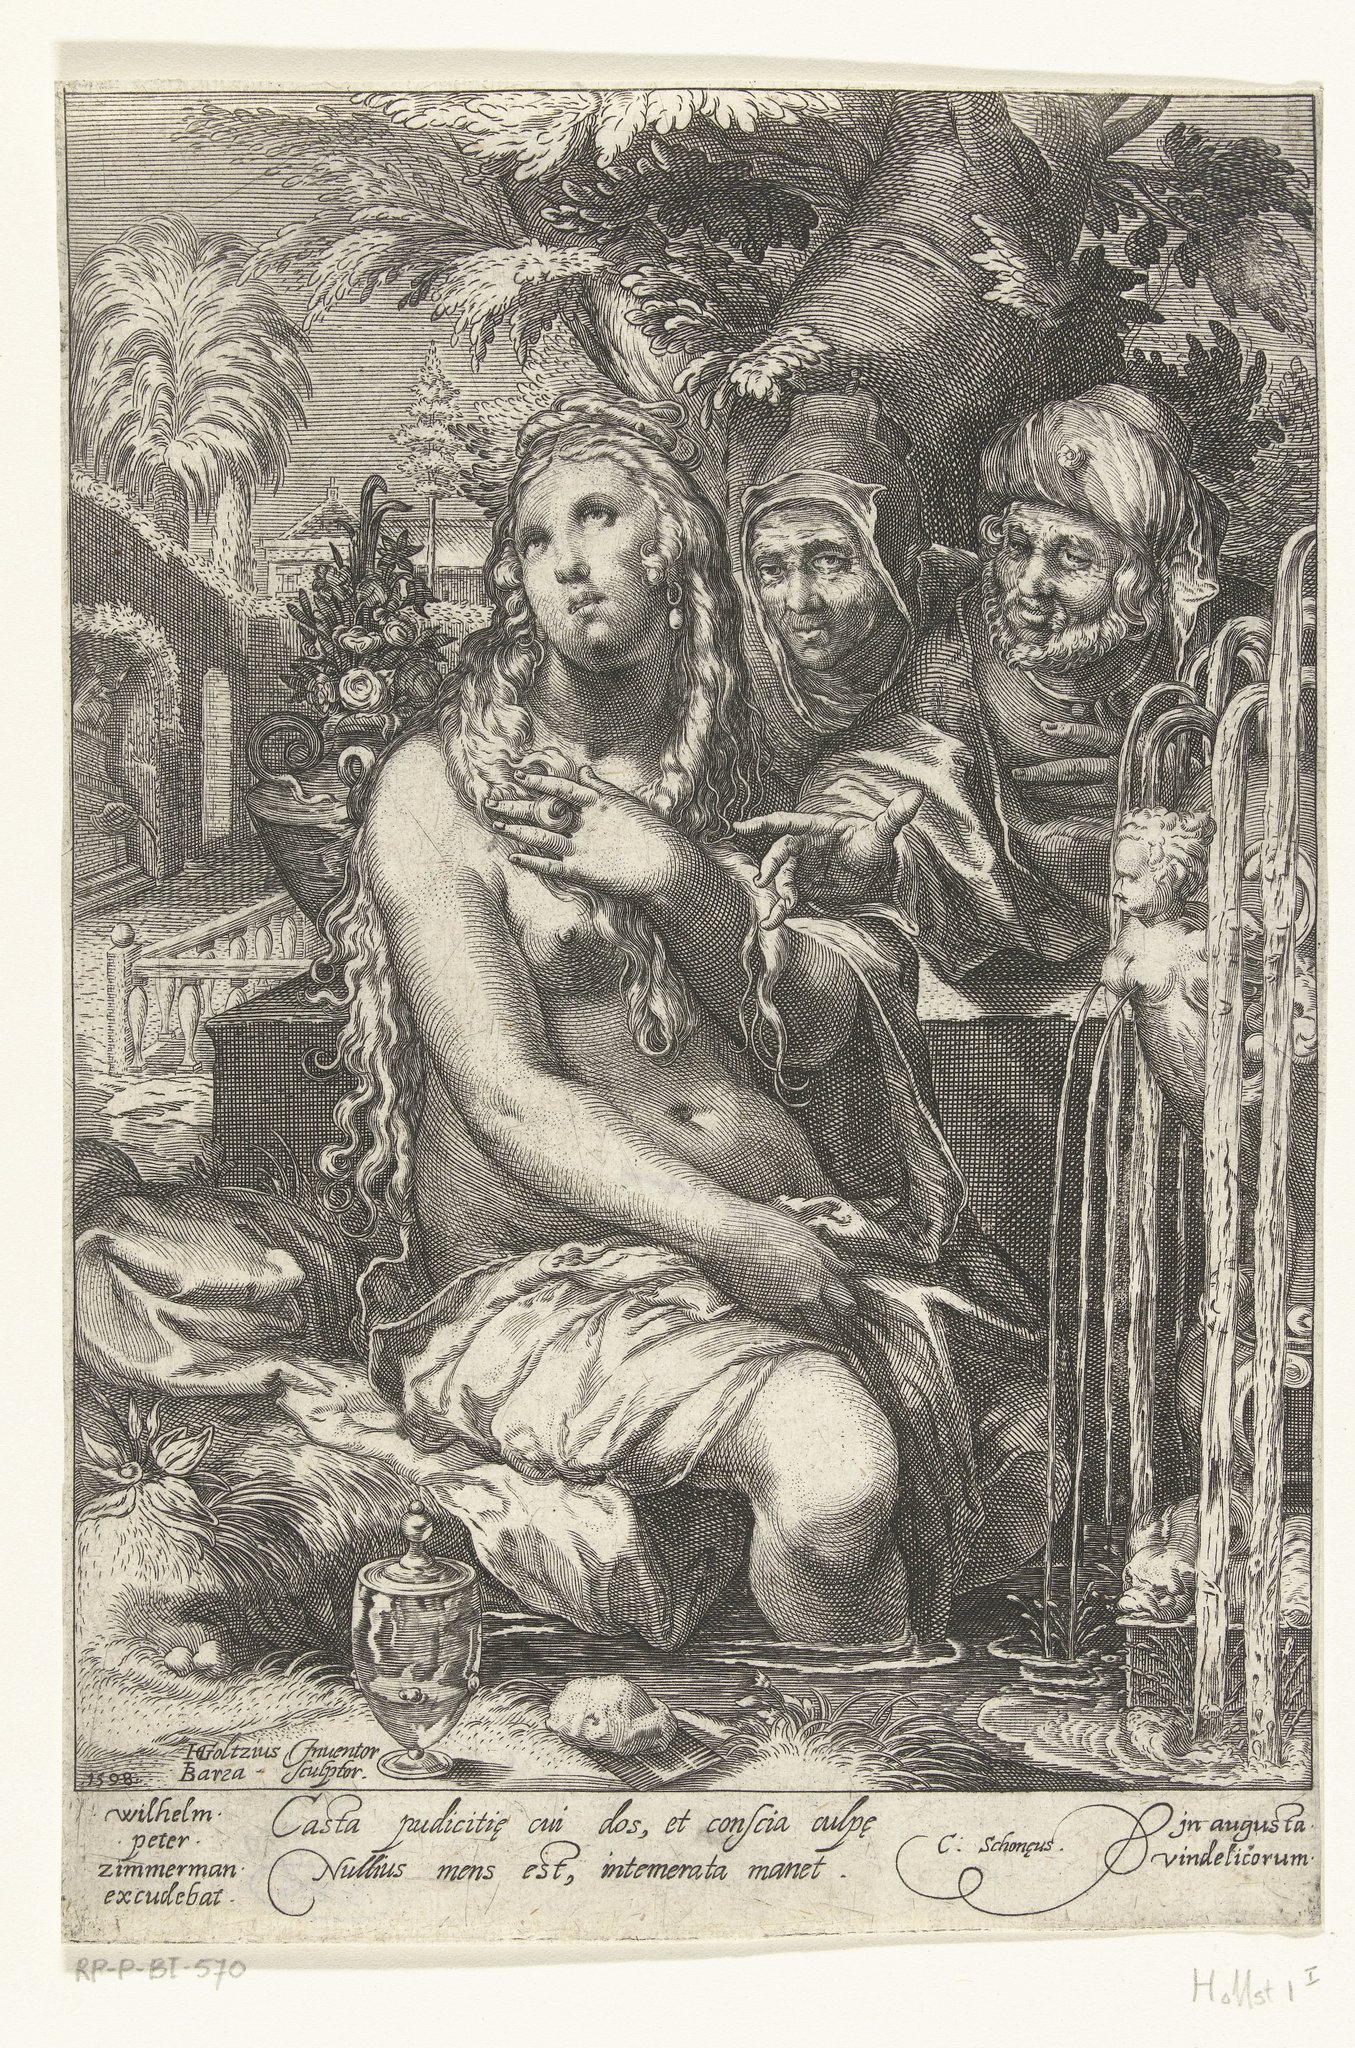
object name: print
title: Susanna baadt zich en wordt bedreigd door twee oudsten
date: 1598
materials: paper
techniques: engraving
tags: the elders making advances towards susanna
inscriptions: collector's mark: Lugt 2228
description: Prent naar ontwerp van Hendrick Goltzius. Goltzius inspireerde zich op ontwerp van Jan Saenredam.